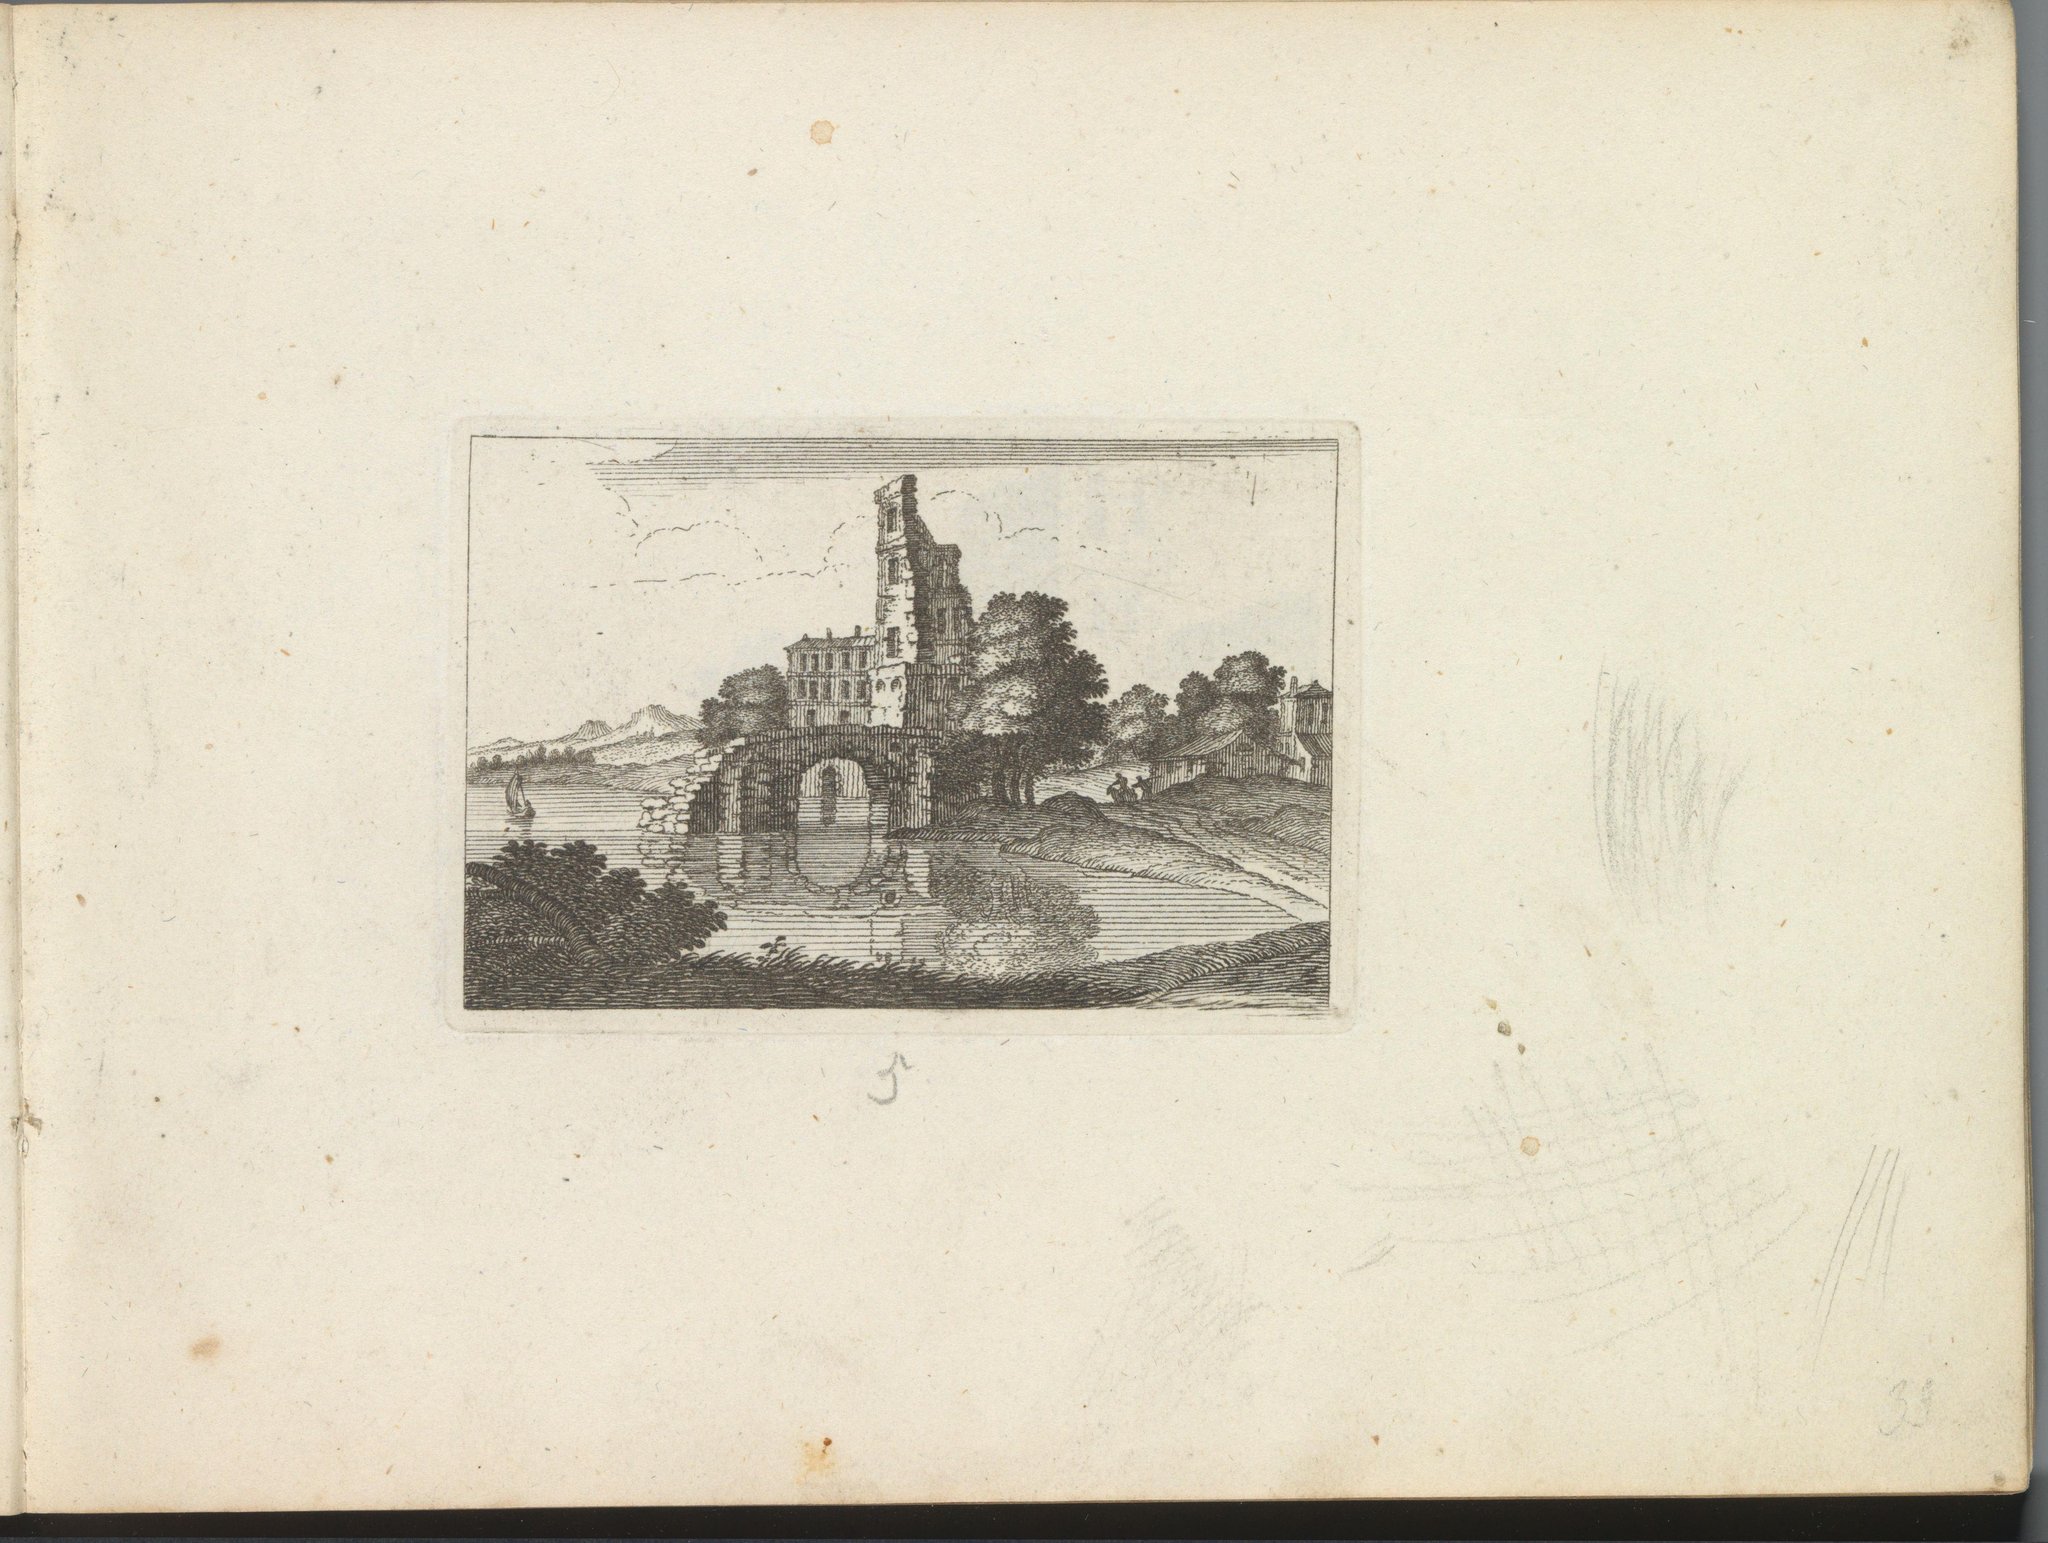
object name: print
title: Landschap met een ruïne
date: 1600-1699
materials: paper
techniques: etching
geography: amsterdam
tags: landscapes in the temperate zone, landscape with ruins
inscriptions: number: ‘5’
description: Landschap met een ruïne aan het water. Links op het water een zeilboot. De prent maakt deel uit van een album.